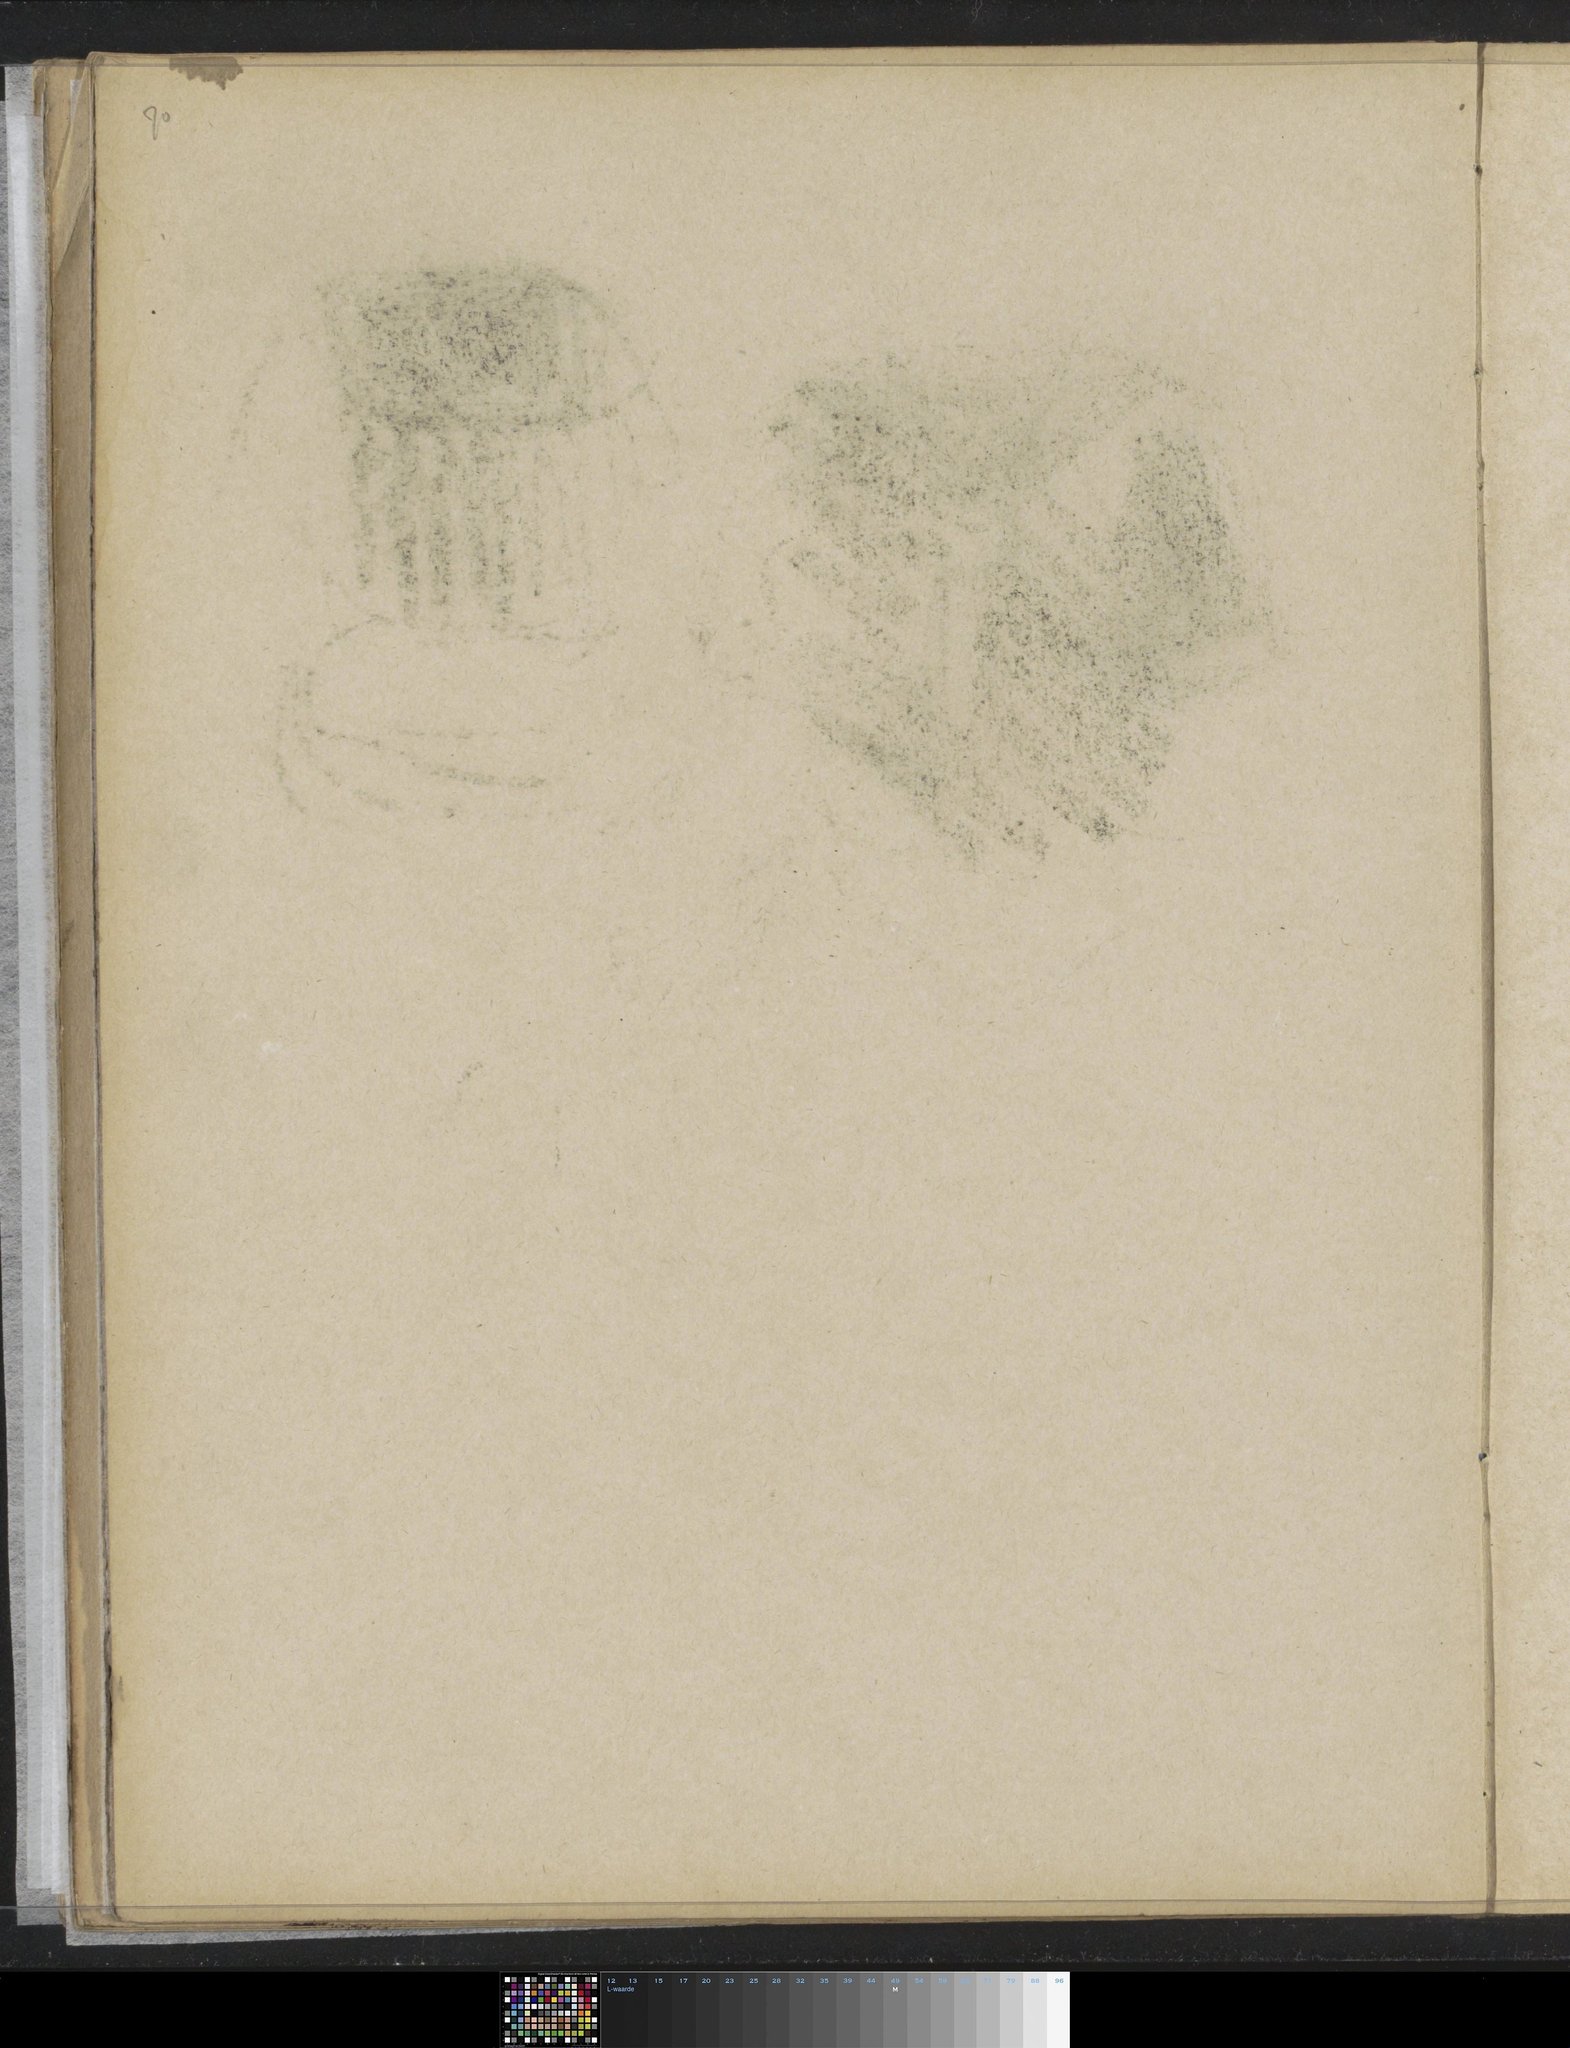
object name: sketchbook leaf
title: Abklatsch van de krijttekening op pagina 71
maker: willem witsen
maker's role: draughtsman, painter, print maker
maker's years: 1860-1923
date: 1886-1891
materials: paper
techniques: printmaking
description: Pagina 70 uit een schetsboek met 40 bladen.